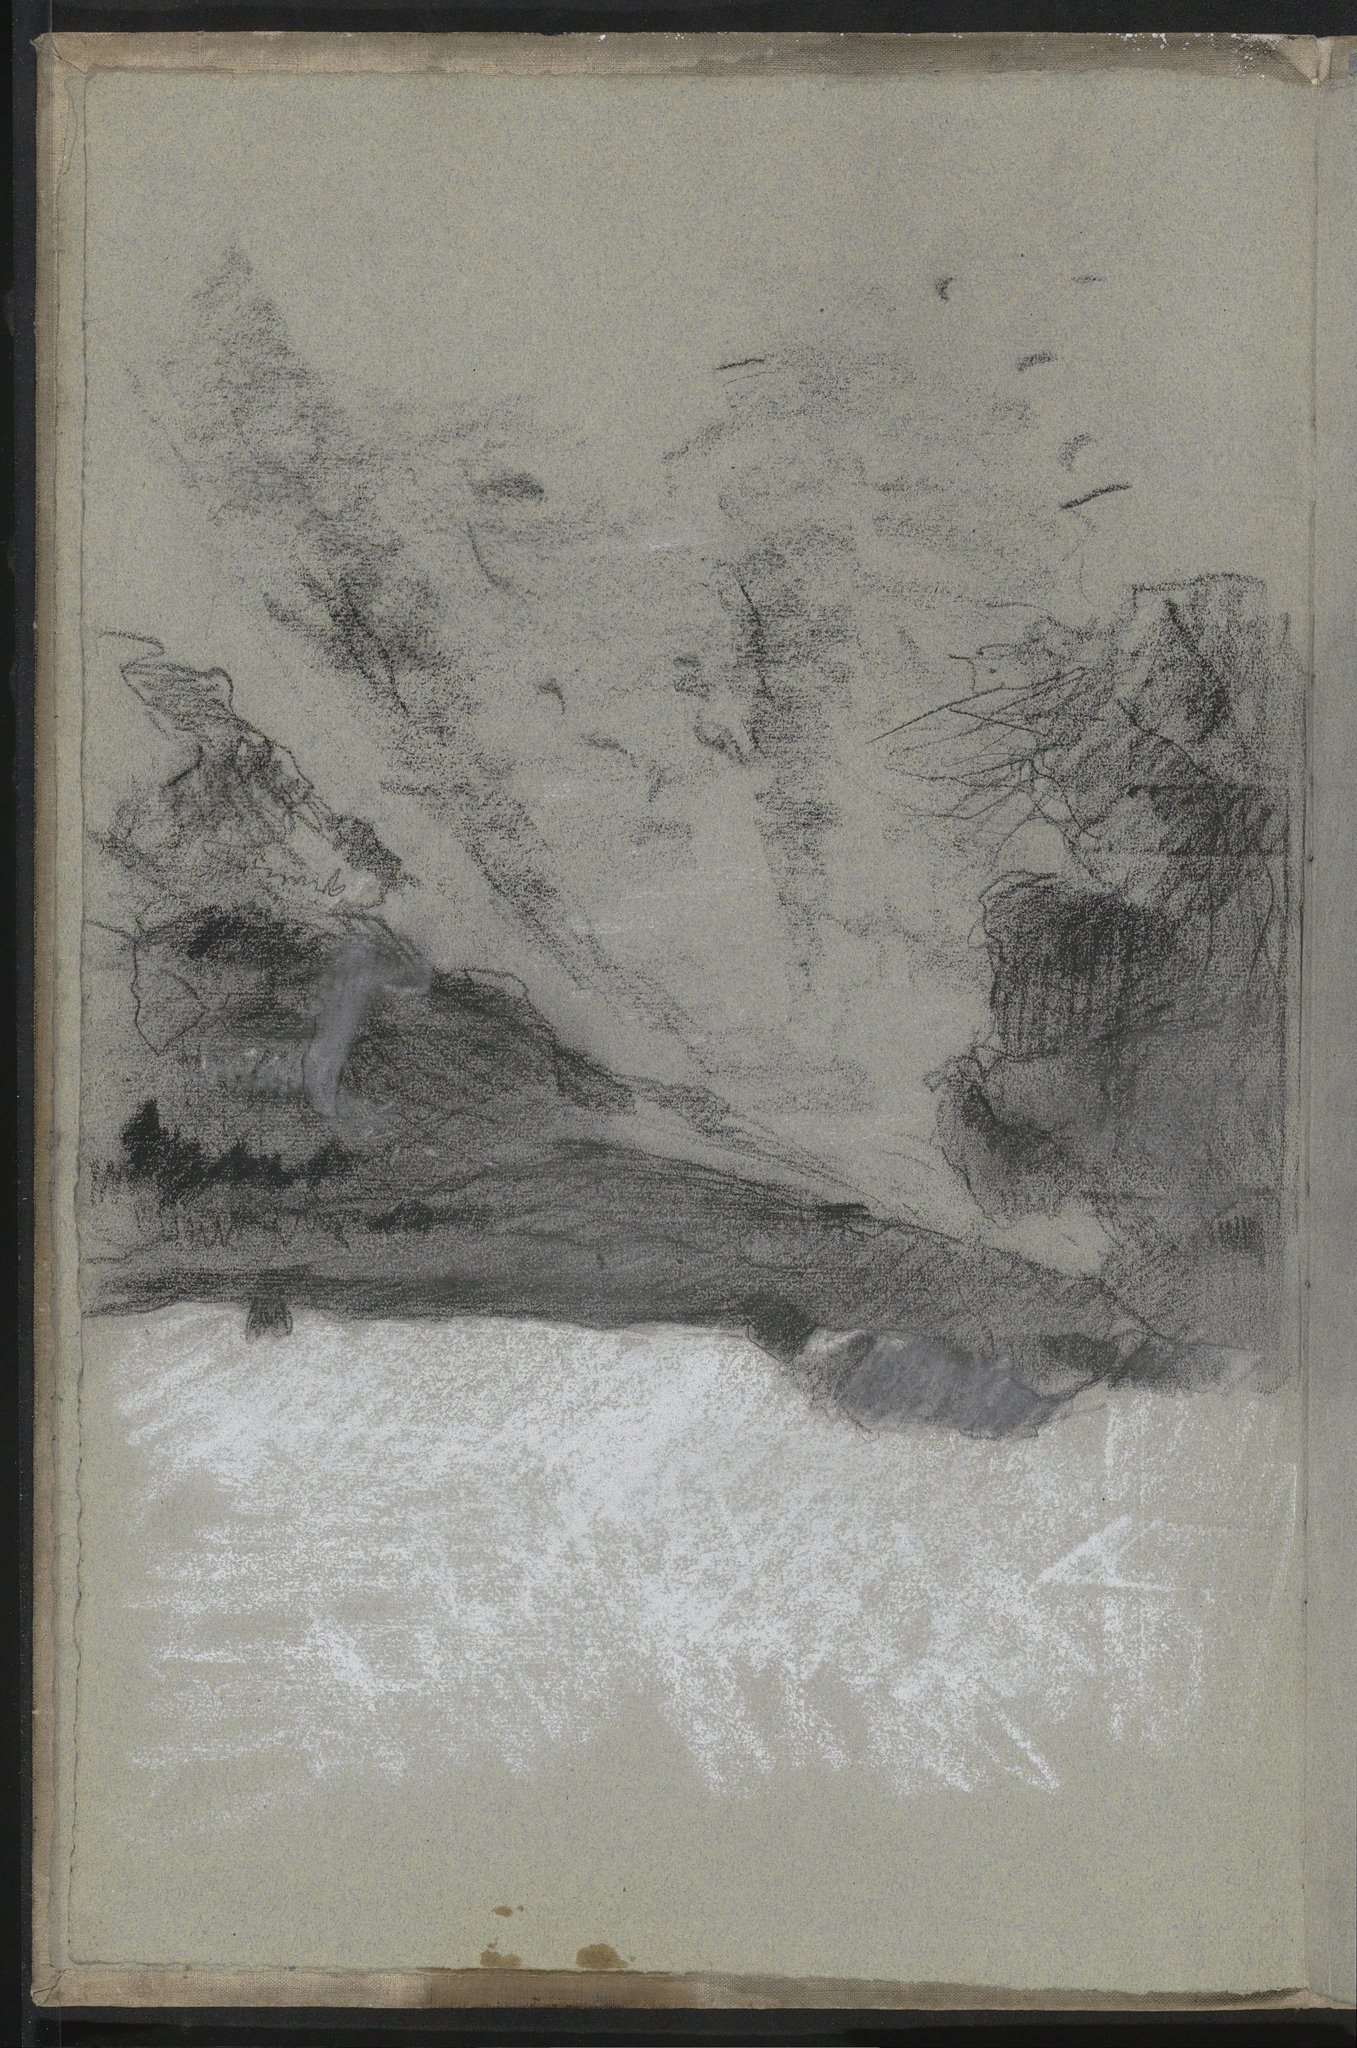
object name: sketchbook leaf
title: Pad door een landschap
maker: willem witsen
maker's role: draughtsman, painter, print maker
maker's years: 1860-1923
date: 1884-1887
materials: chalk, paper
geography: ewijkshoeve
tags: landscapes in the temperate zone, road, path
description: Pagina 2 uit een schetsboek met 45 bladen vervaardigd rond de Ewijkshoeve.